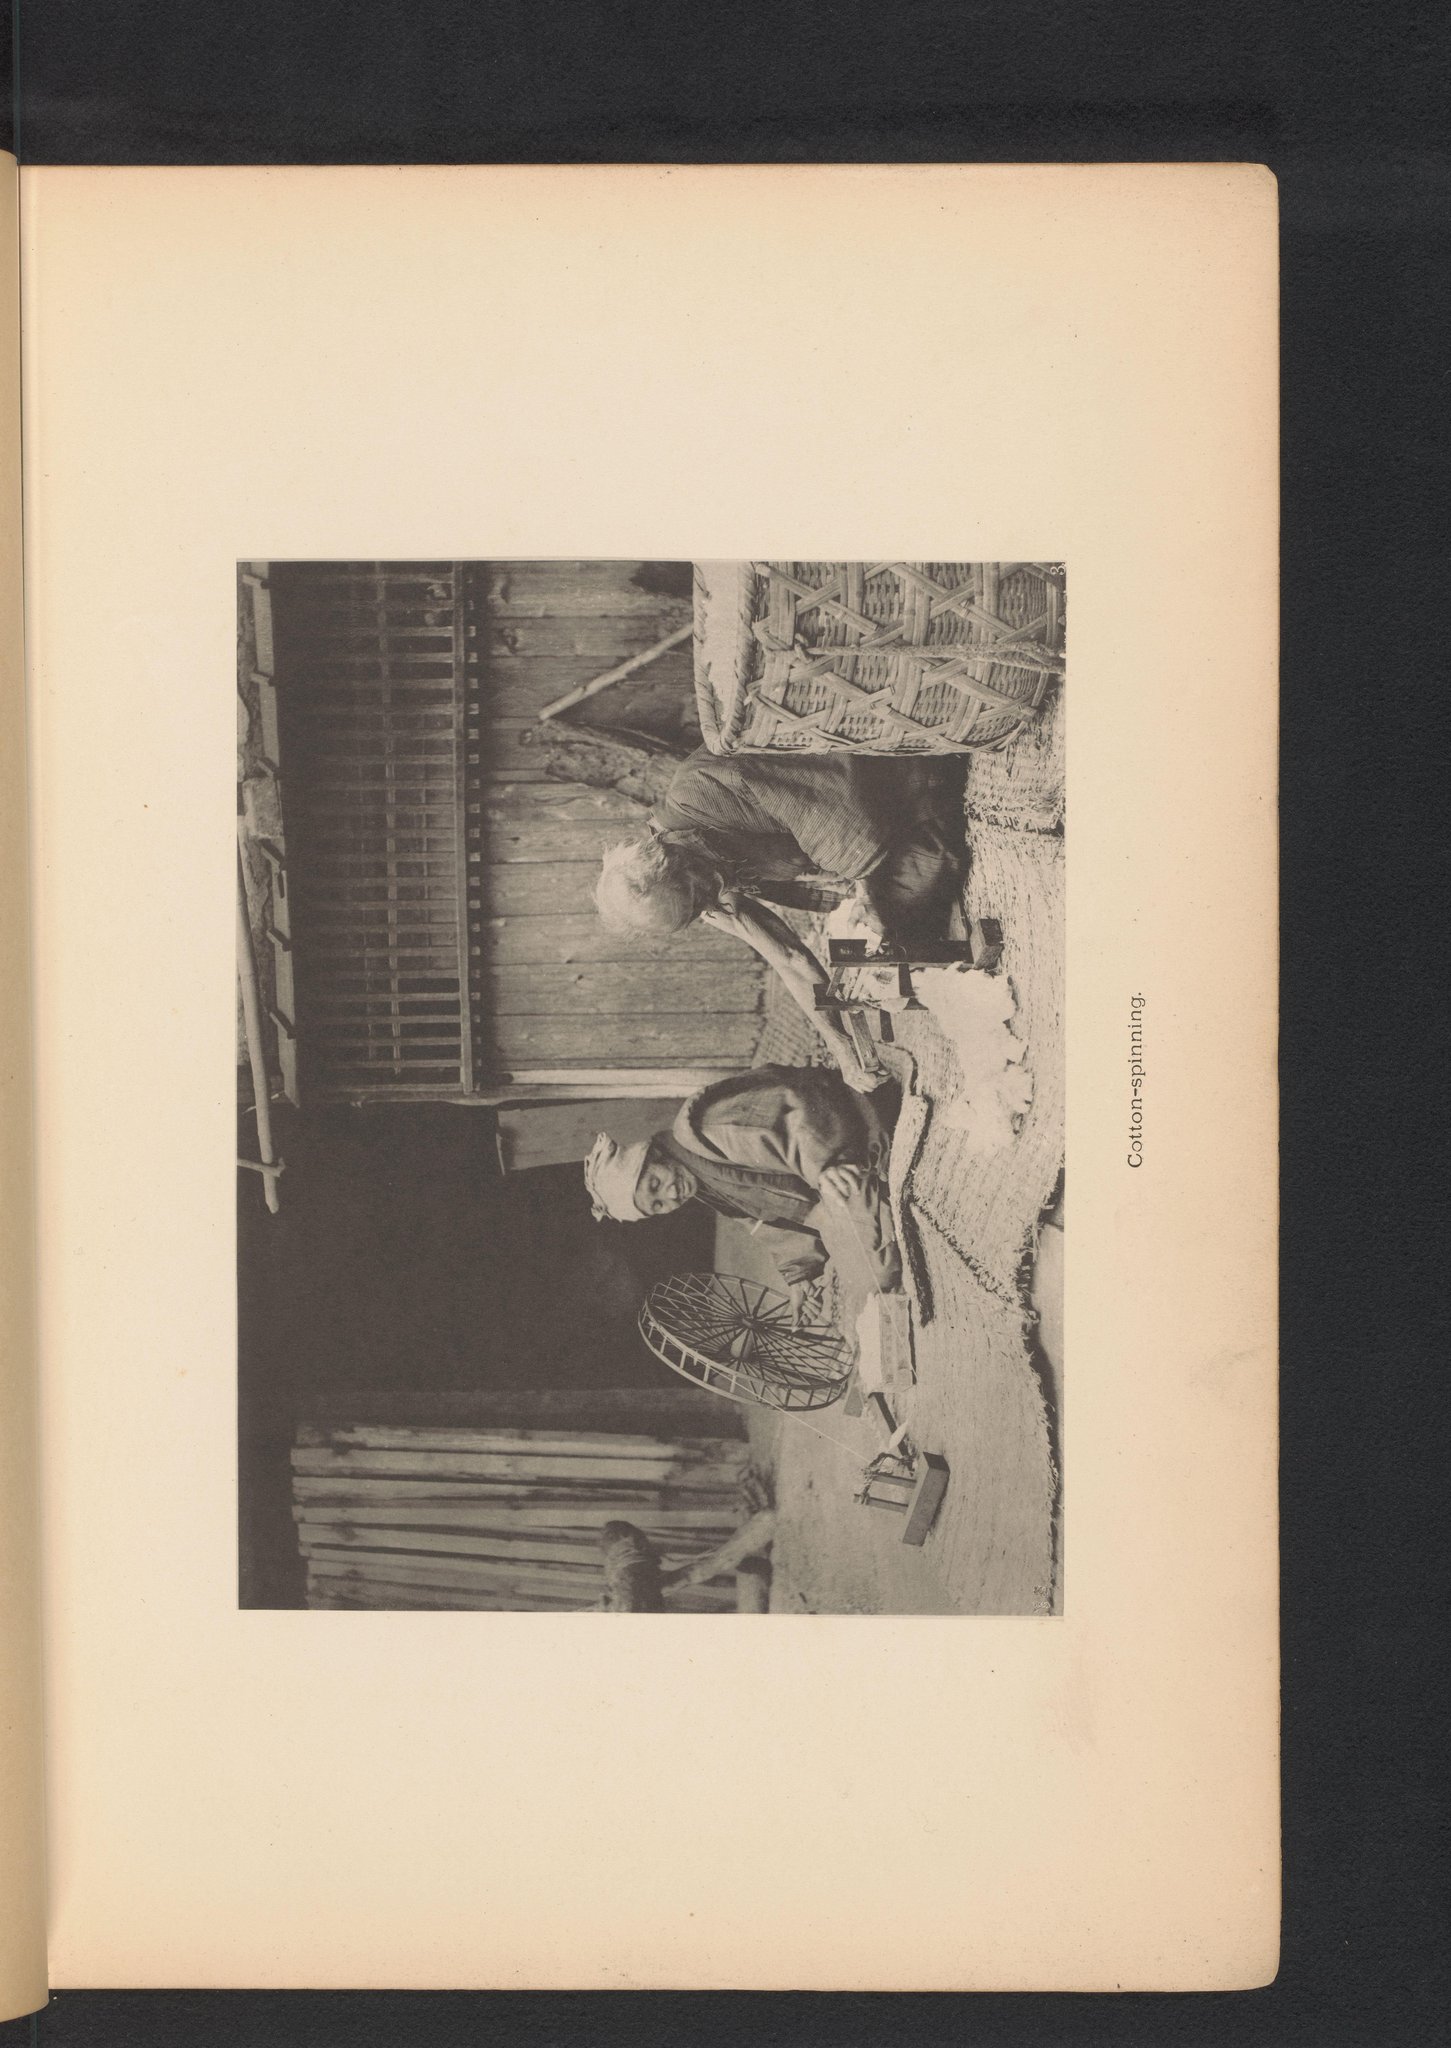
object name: photomechanical print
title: Japanse man en vrouw spinnen garen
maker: kazumasa ogawa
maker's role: auteur, fotograaf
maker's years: 1860-1929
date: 1890-1895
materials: paper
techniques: photograph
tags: old man, old woman, spinning (manufacture of yarn)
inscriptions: number: ‘3’